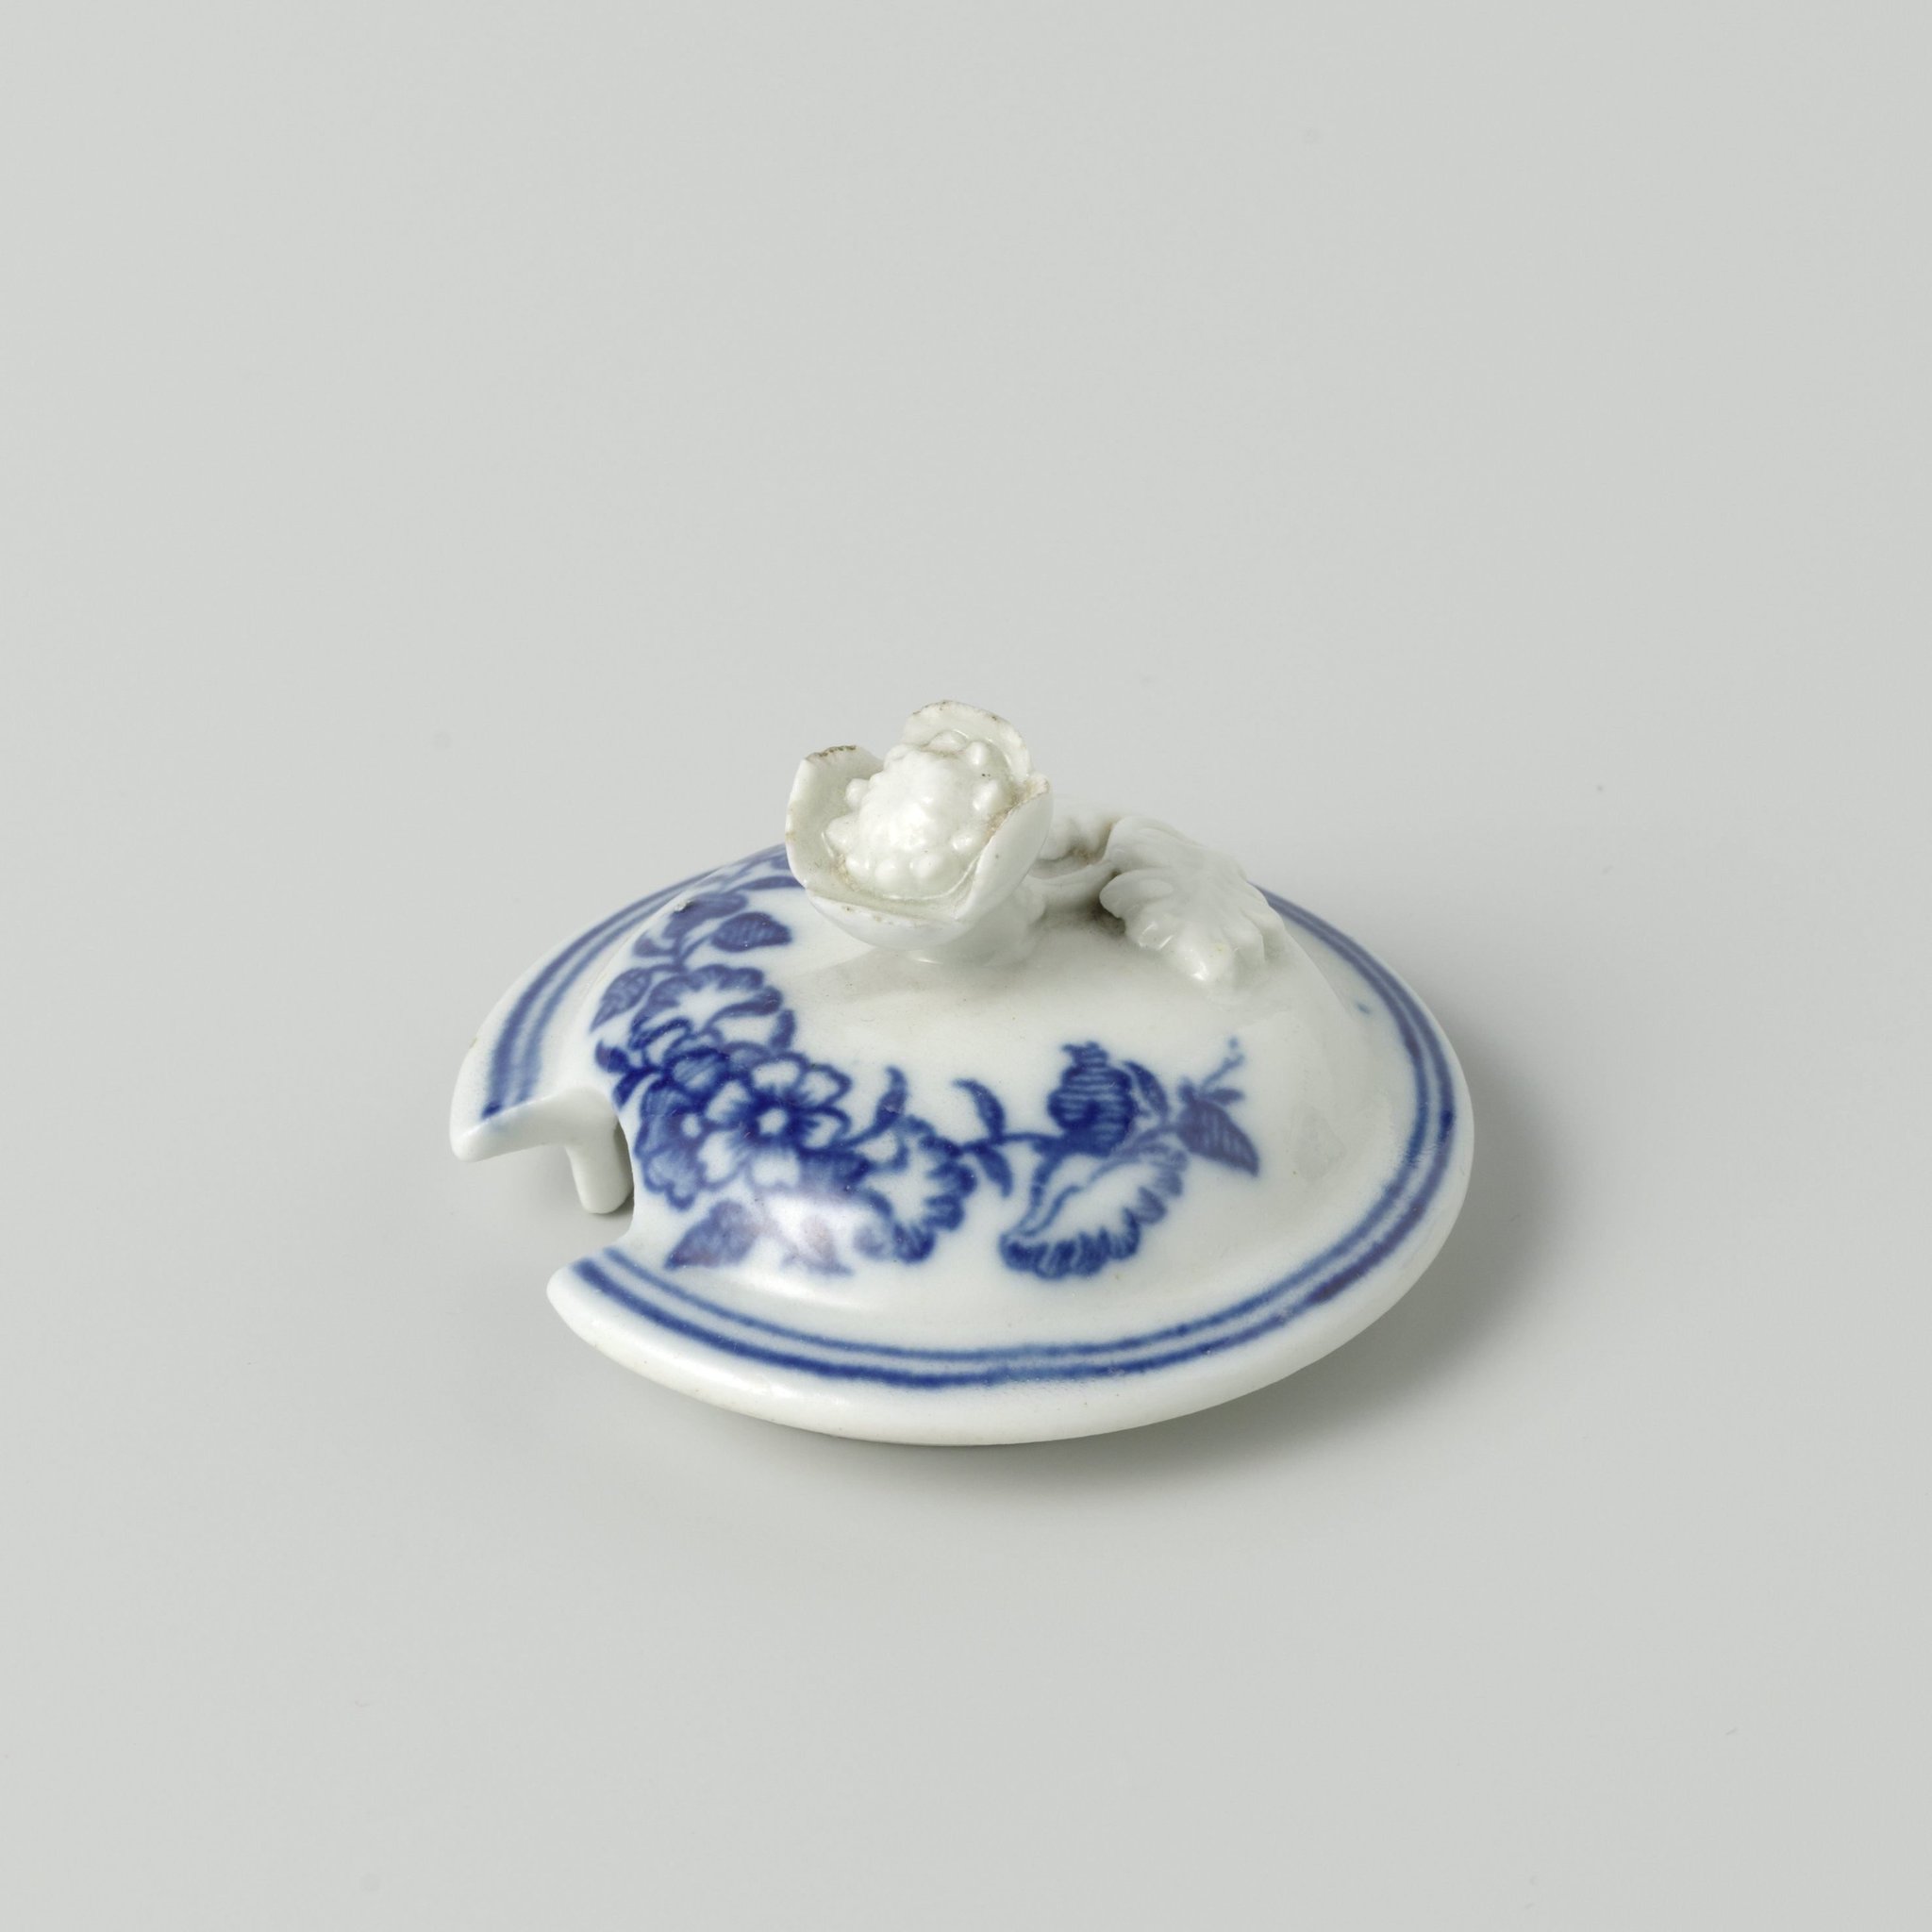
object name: lid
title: Deksel van mosterdpot met bloemdecoratie met vlinder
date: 1772-1804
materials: porcelain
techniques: stenciling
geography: langley mill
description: Deksel van mosterdpot met deksel en lepel van porselein. Het deksel is versierd met een bloemenrank en is afgezet met concentrische cirkels. Dekselknop in de vorm van een bloem met bladeren.